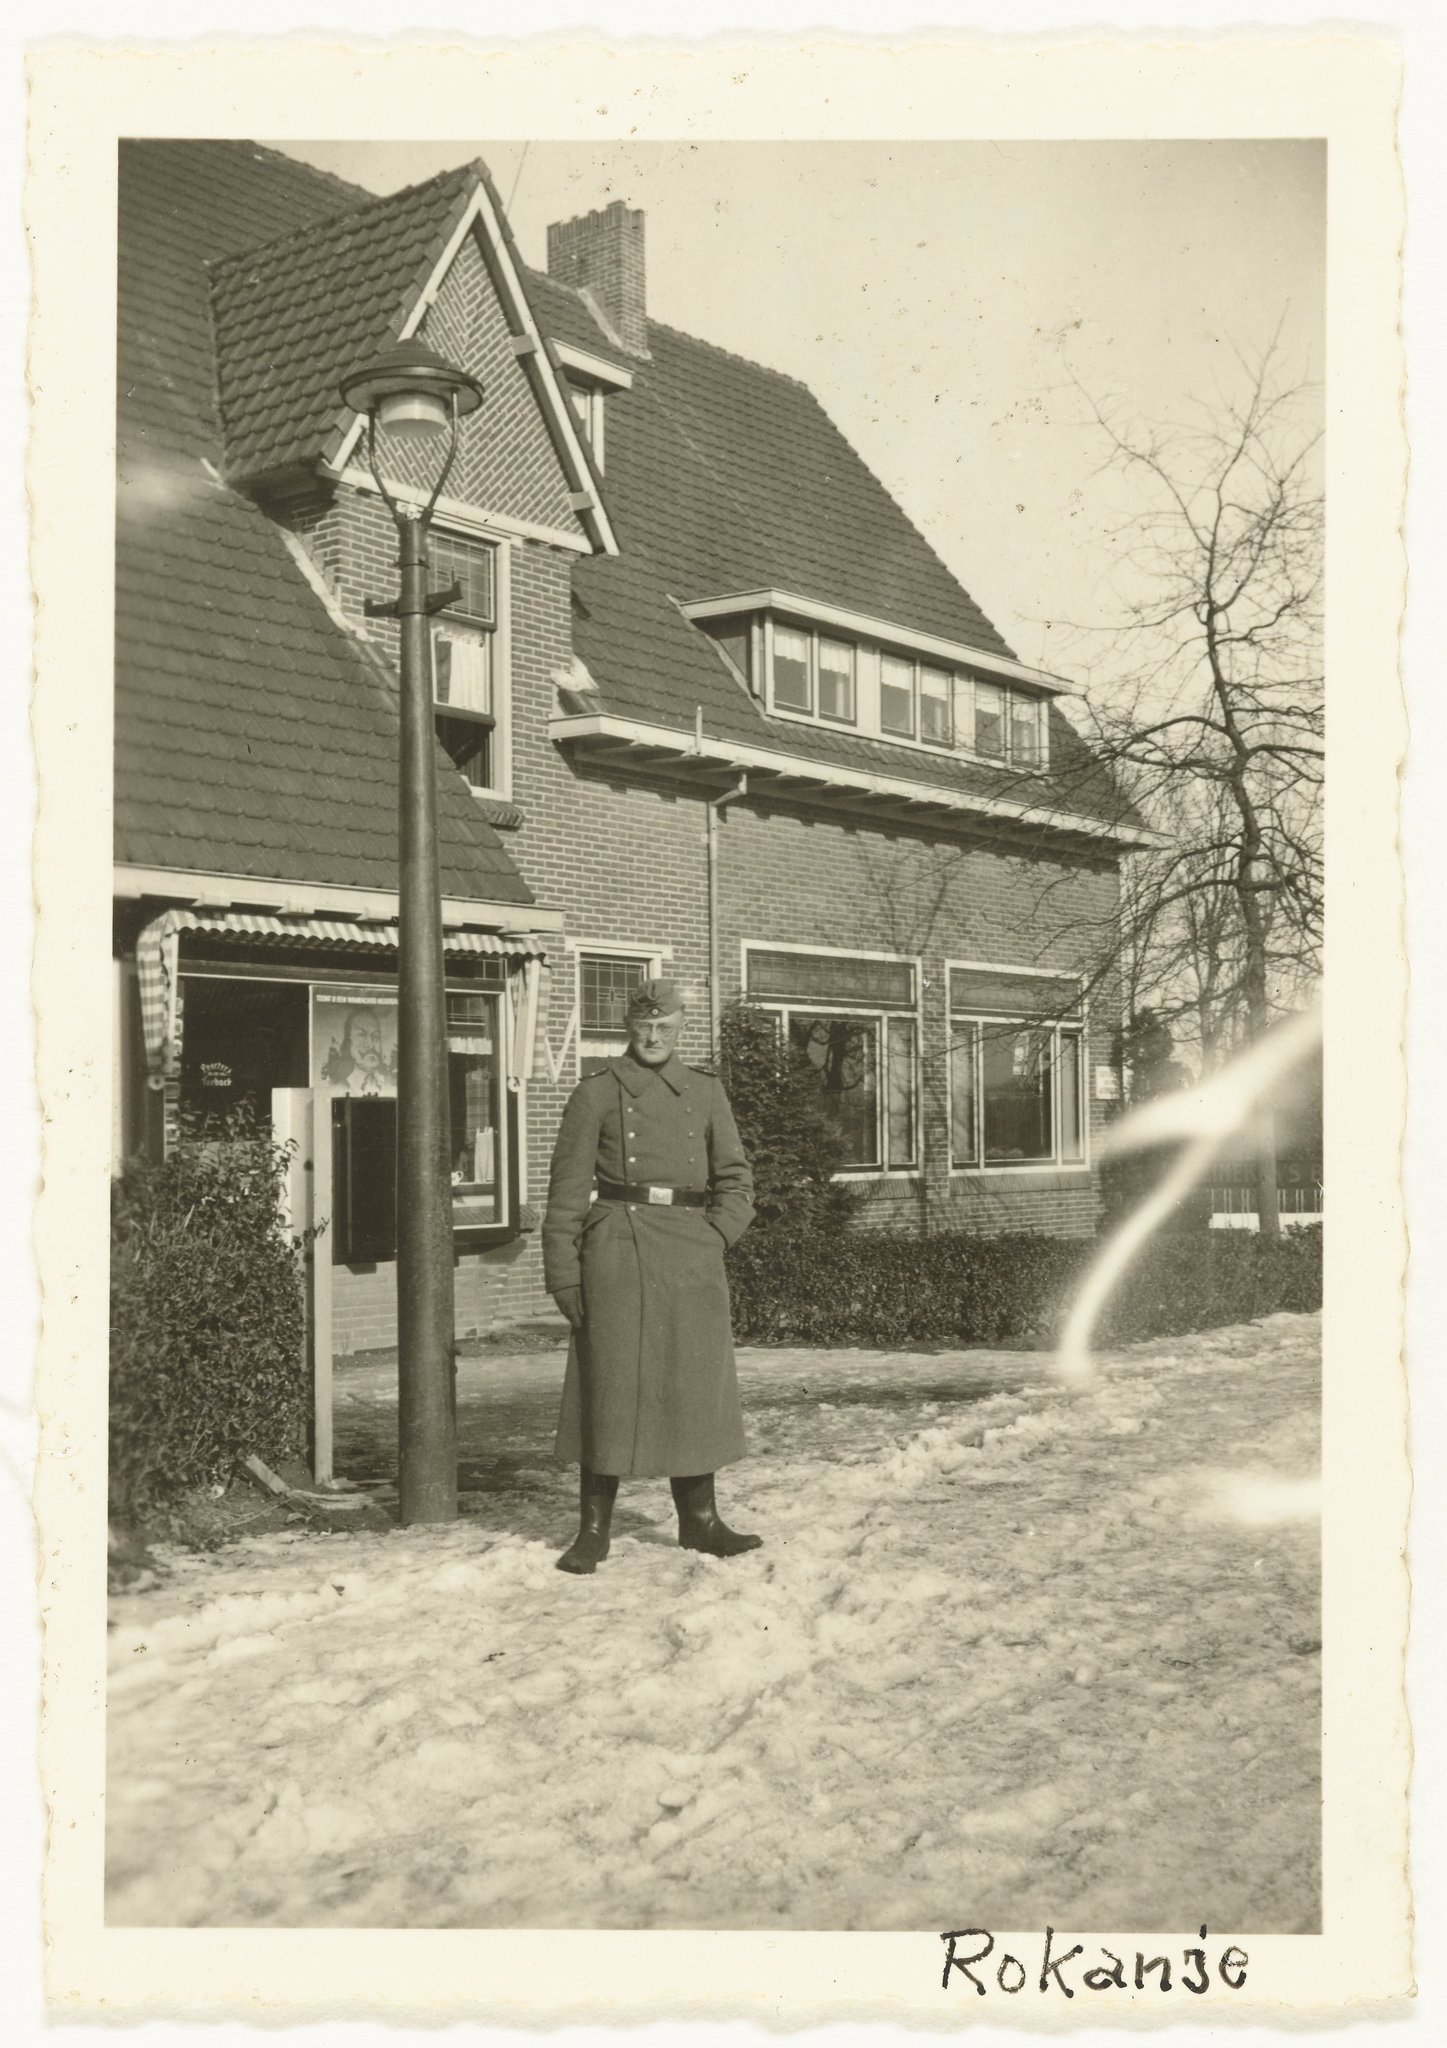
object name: photograph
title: Wehrmacht soldaat voor een huis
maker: Anonymous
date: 1940-1941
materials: photographic support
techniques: gelatin silver print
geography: rockanje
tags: occupation ~ war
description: Bij een huis staat een Wehrmacht soldaat, er ligt sneeuw. De soldaat draagt een bril.